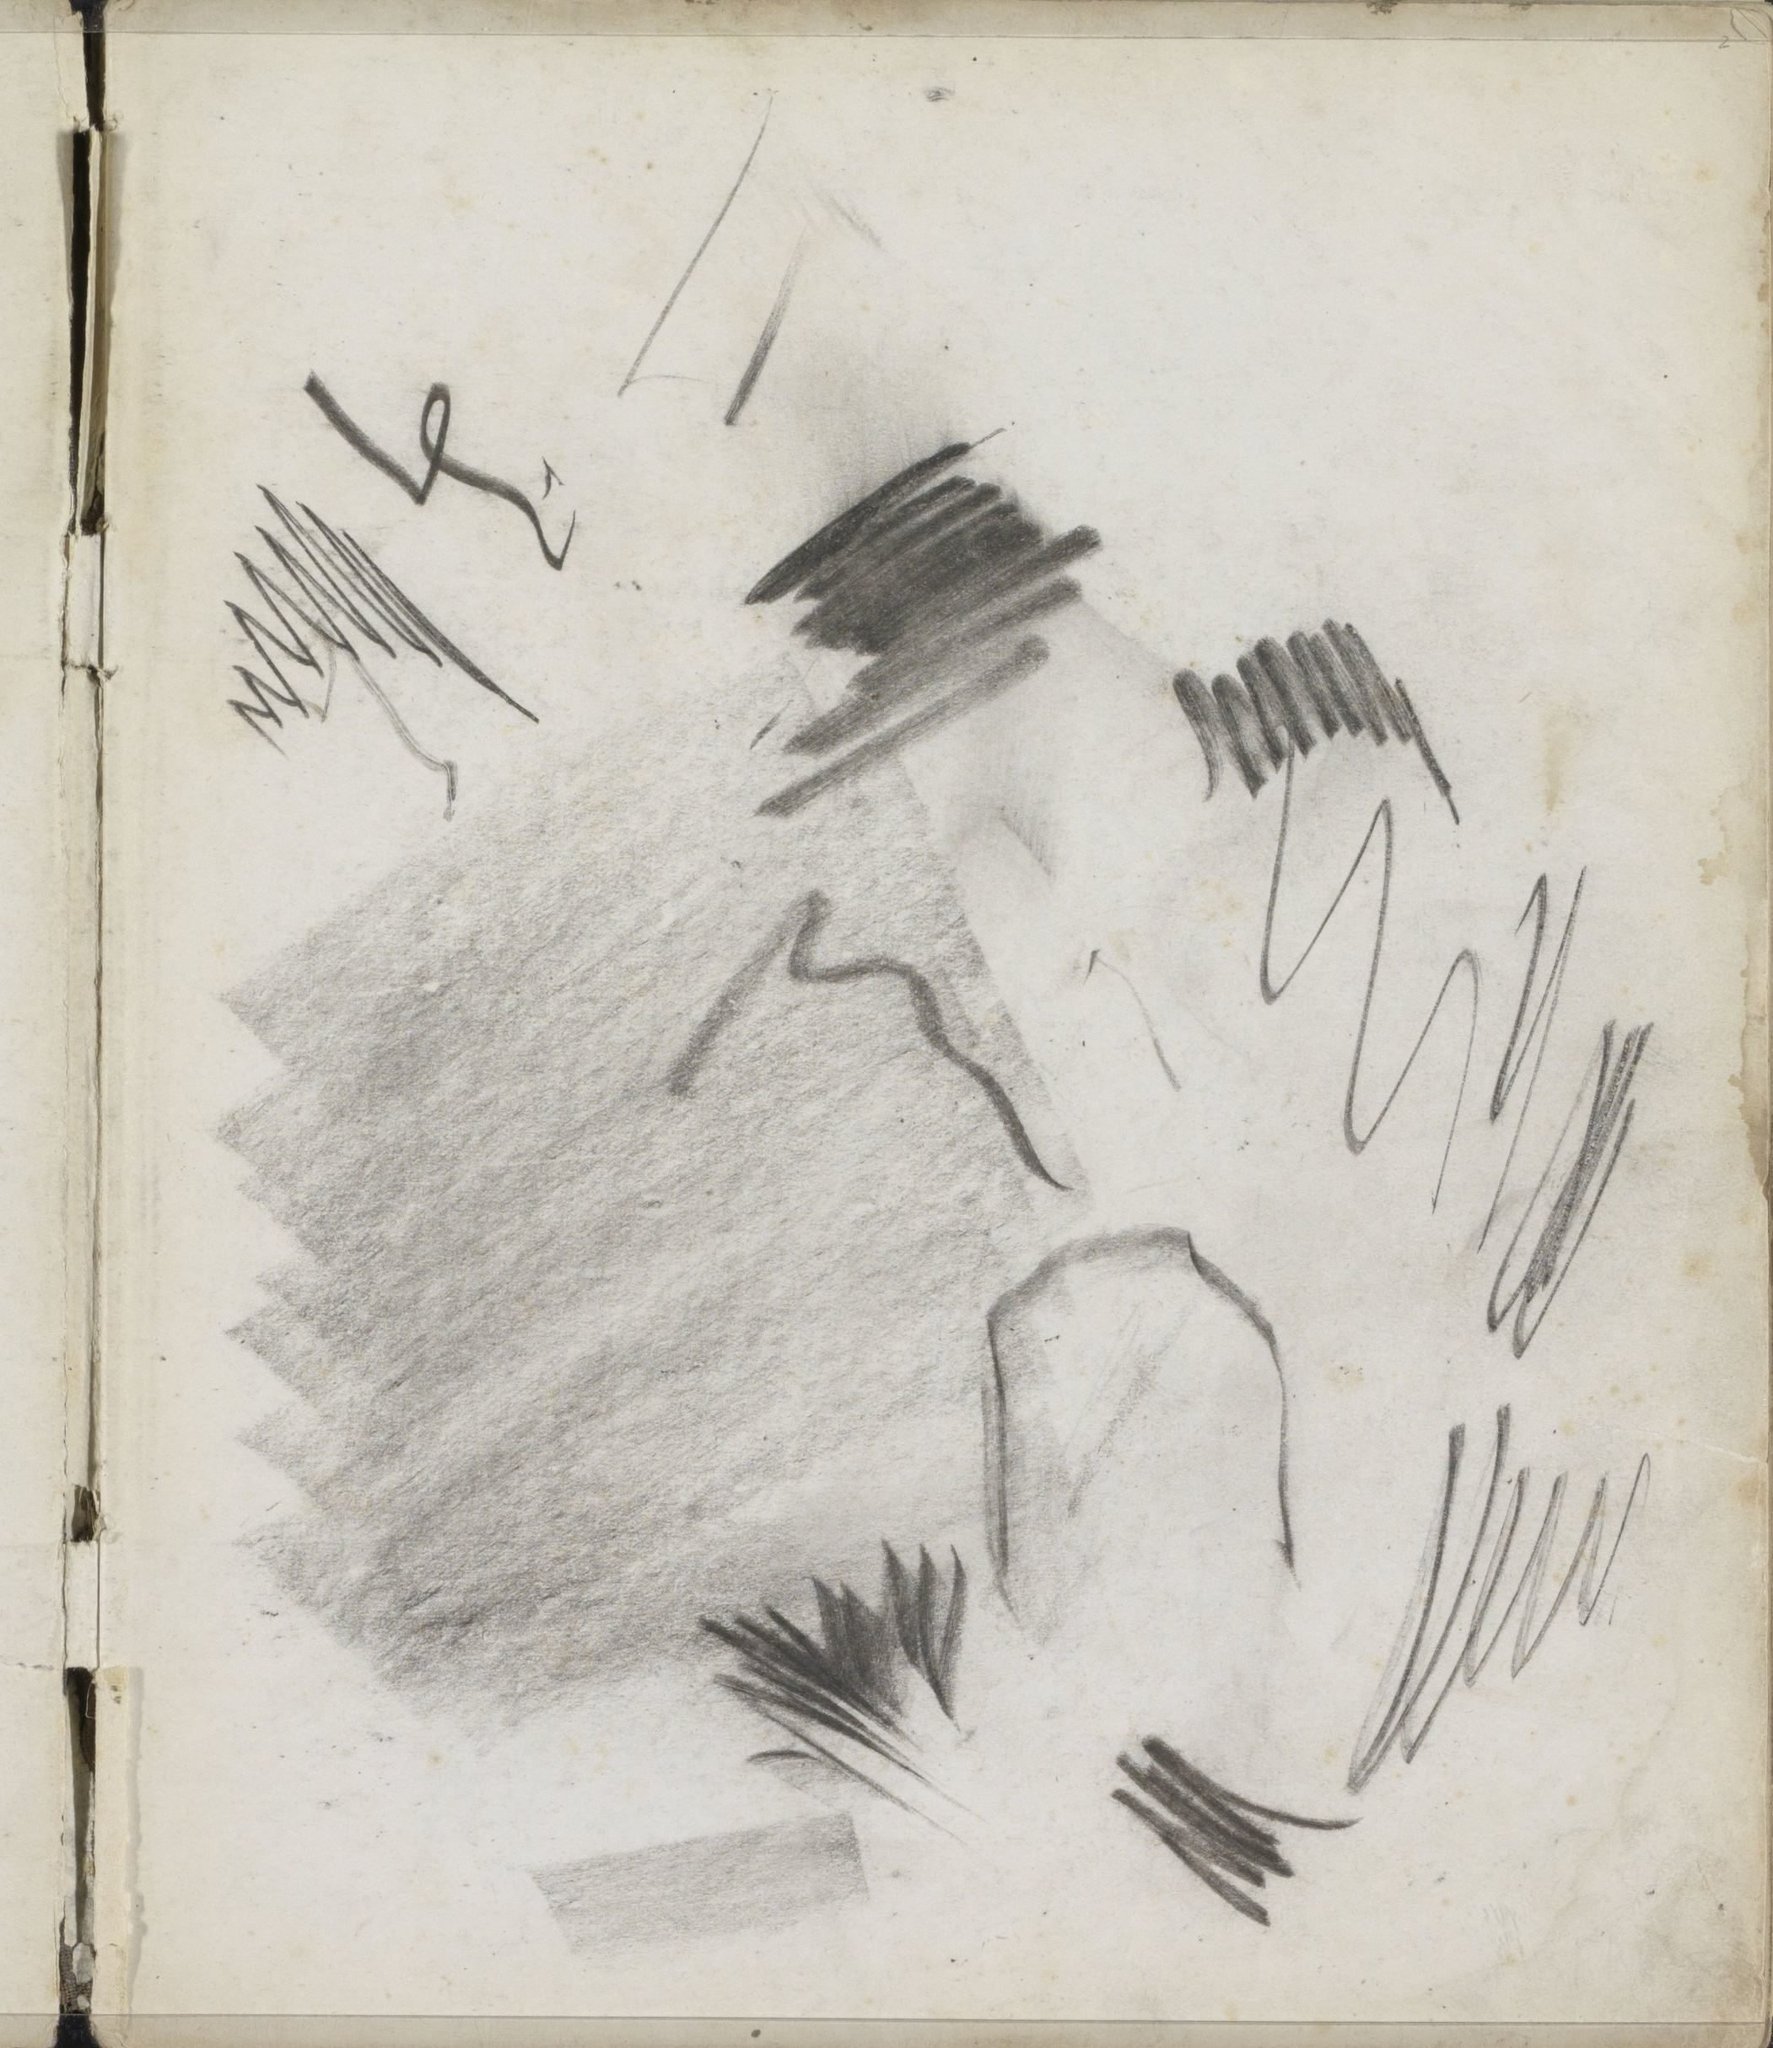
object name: sketchbook leaf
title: Studie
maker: george hendrik breitner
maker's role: draughtsman, painter, print maker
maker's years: 1857-1923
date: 1880-1906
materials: chalk, paper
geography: netherlands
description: Pagina 2 uit een schetsboek met 81 bladen.